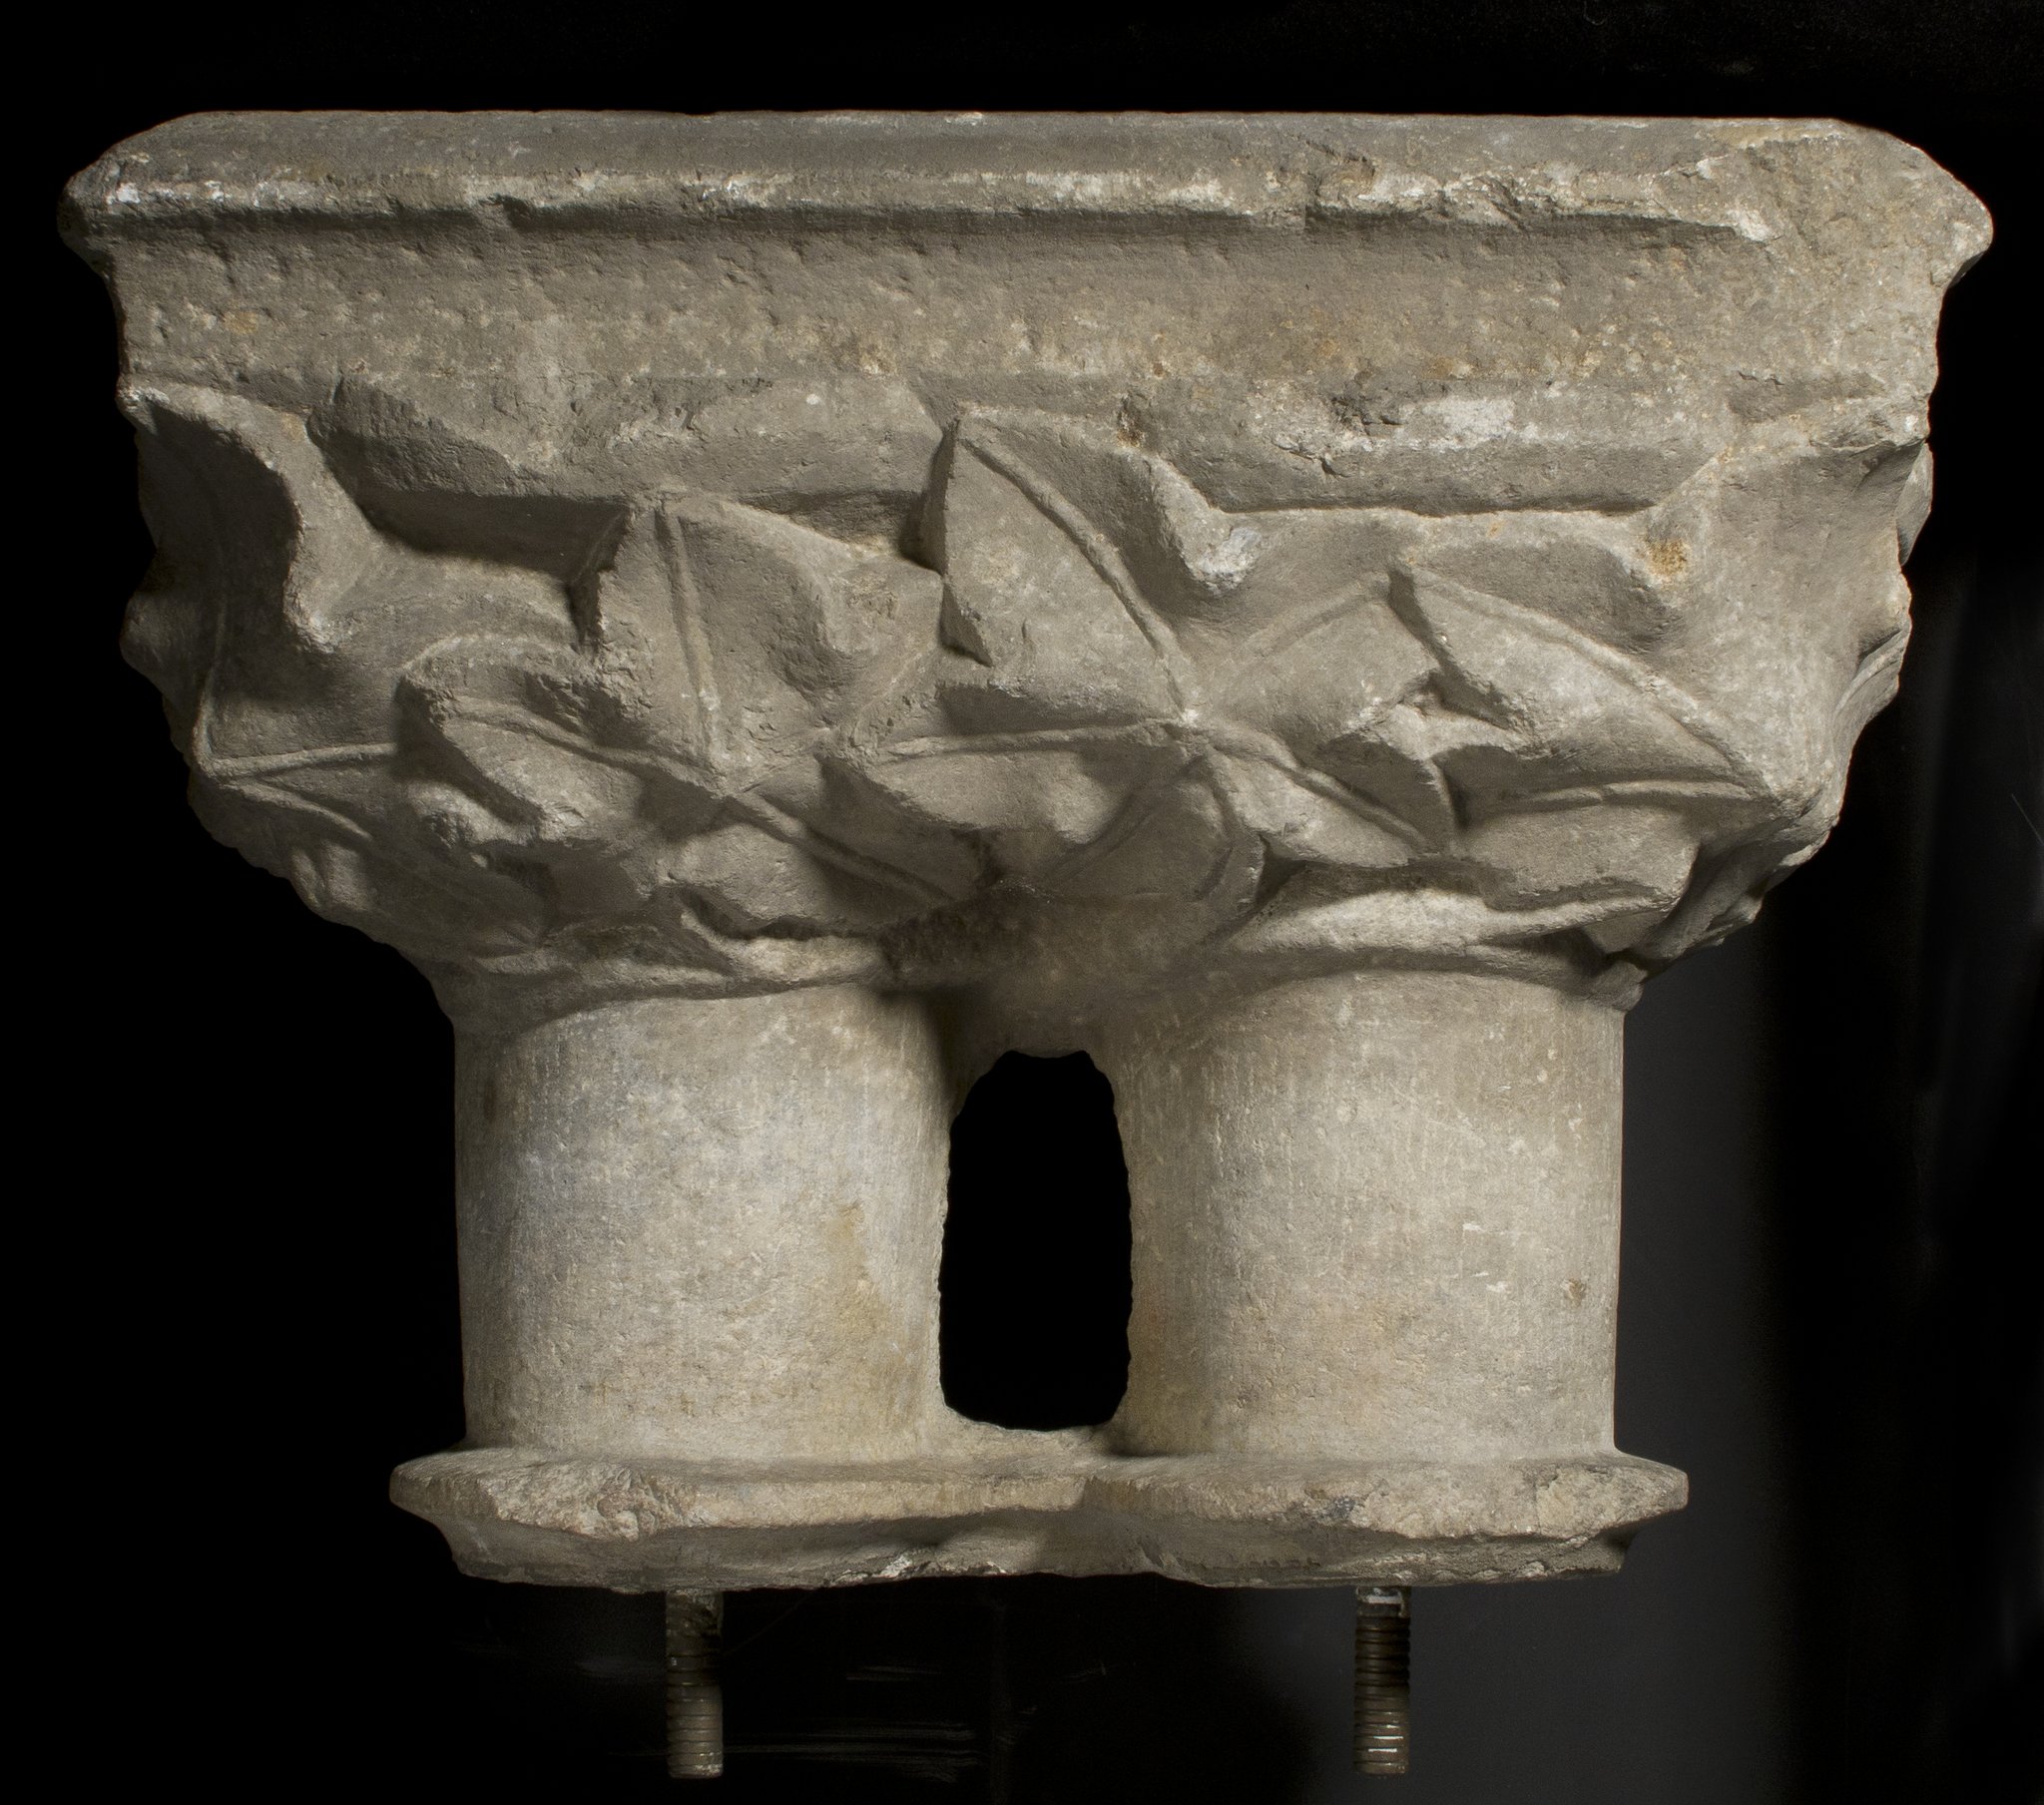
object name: double column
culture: french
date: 1201-1400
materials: marble